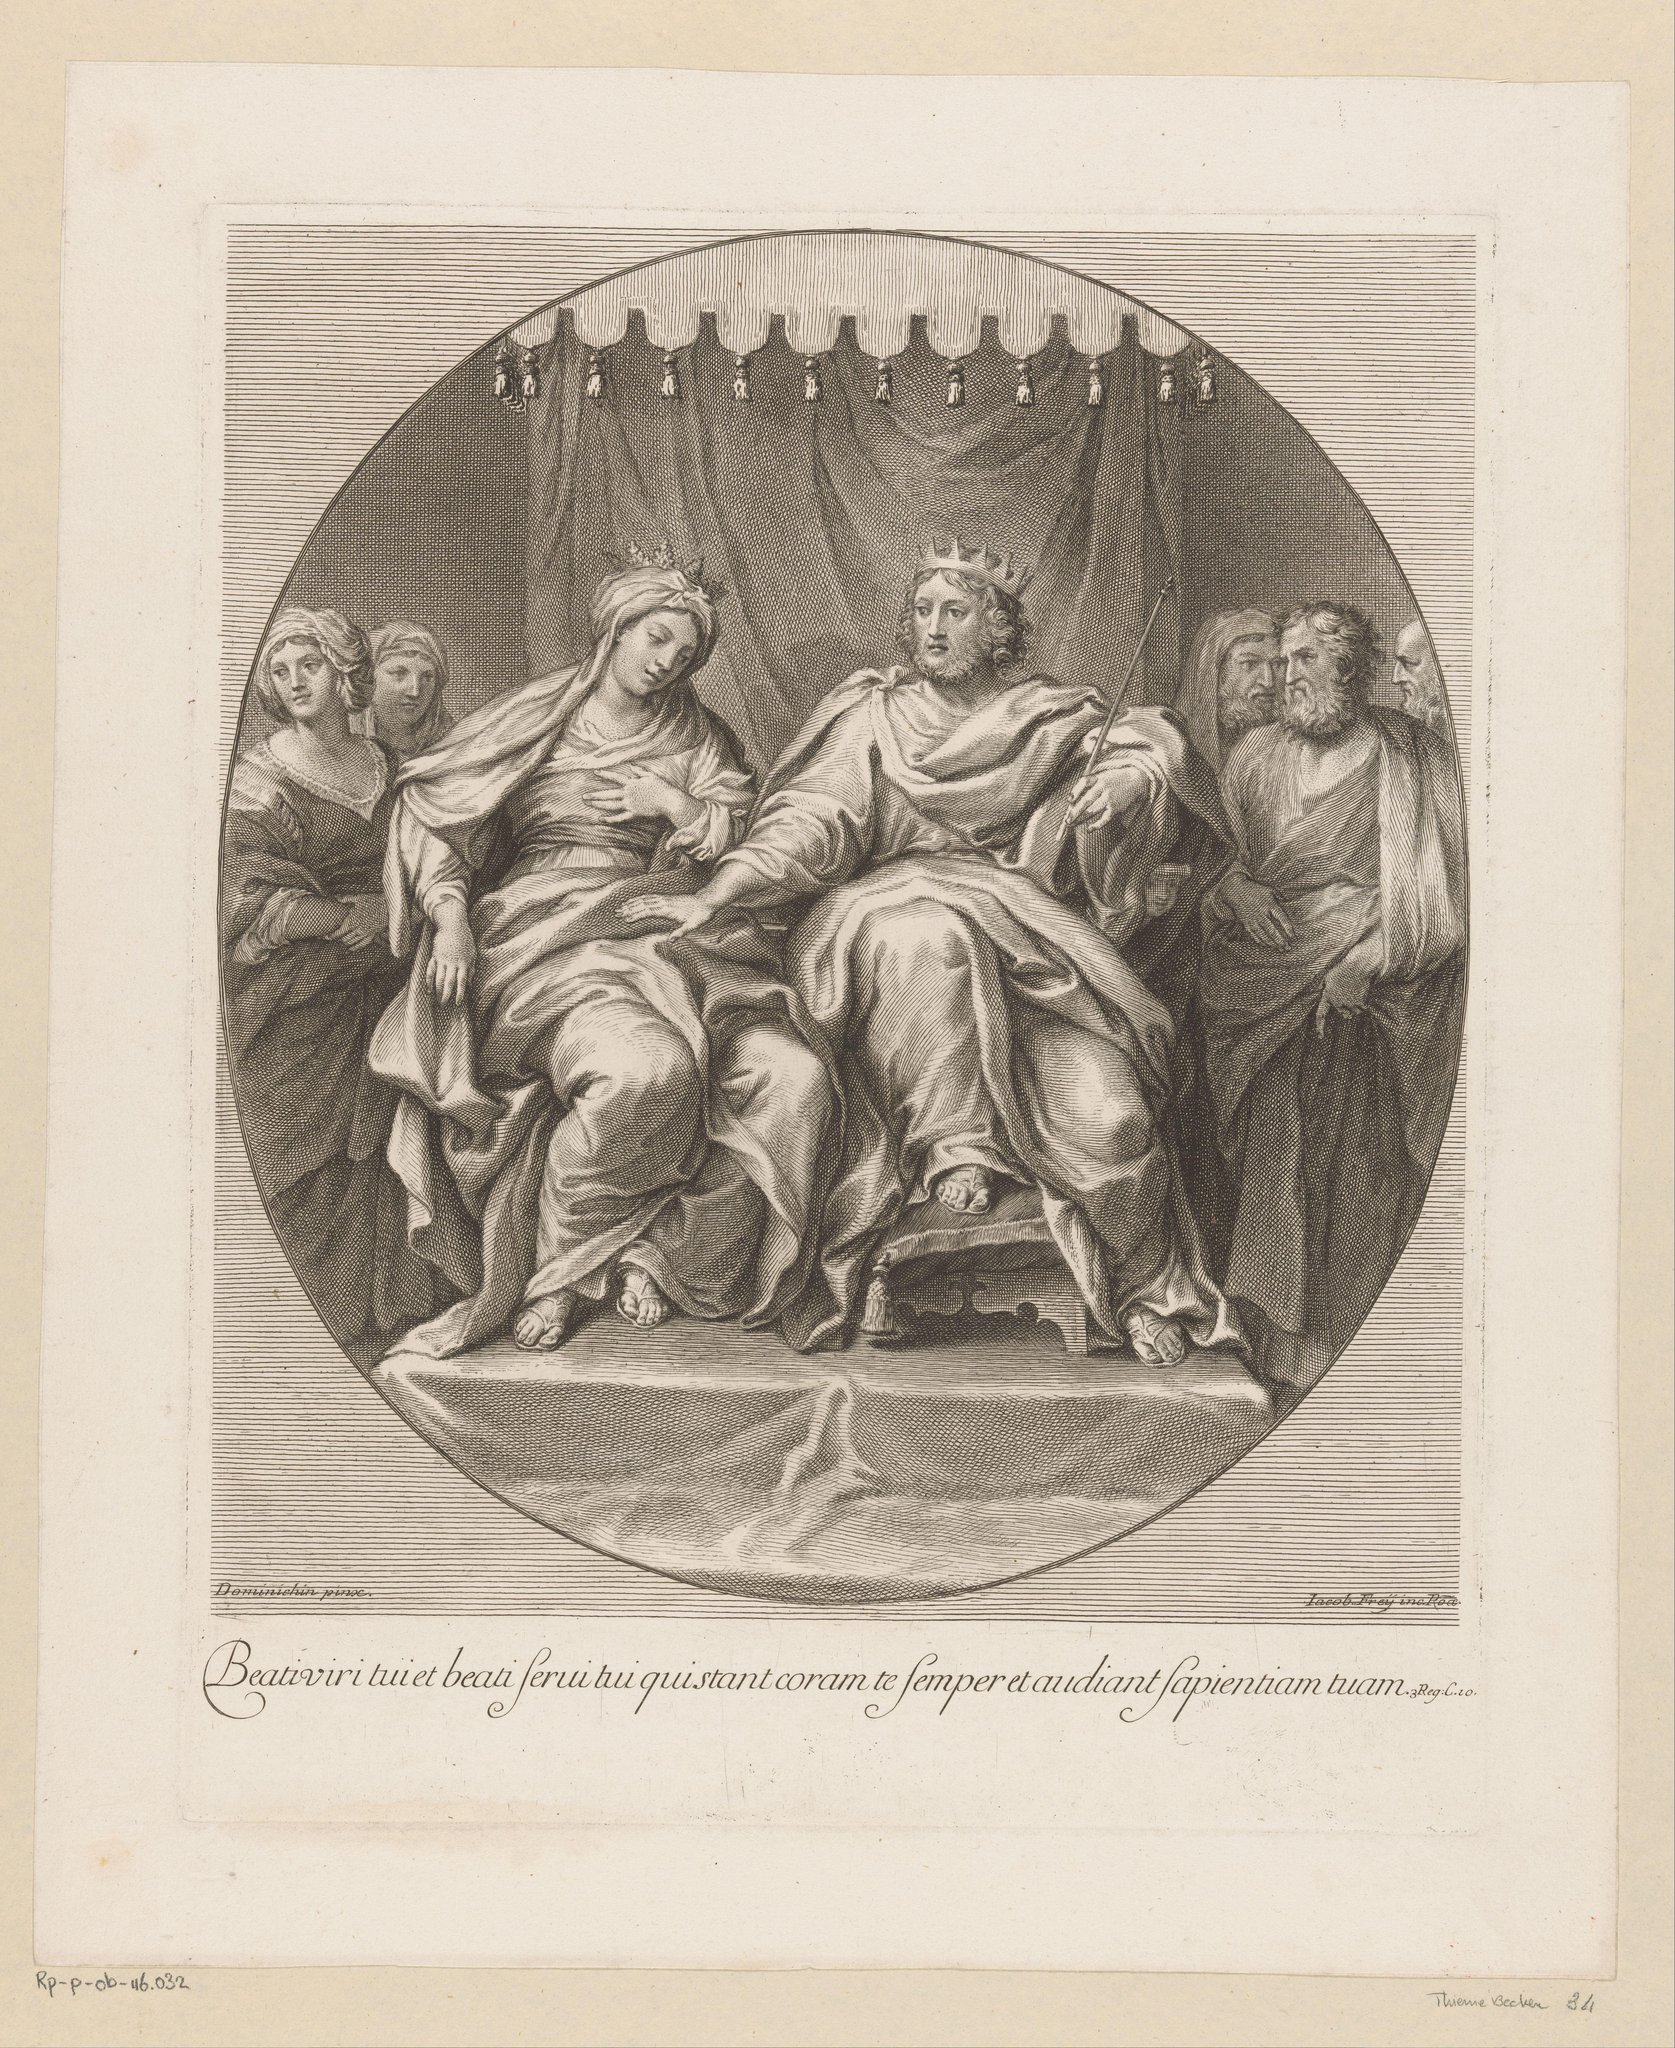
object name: print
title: Salomo en Batseba op de troon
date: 1718-1719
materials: paper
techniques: engraving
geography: rome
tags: bathsheba enthroned at solomon's right hand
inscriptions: collector's mark: Lugt 240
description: Naar één van de vier tondo's door Domenichino in de San Silvestro al Quirinale in Rome.